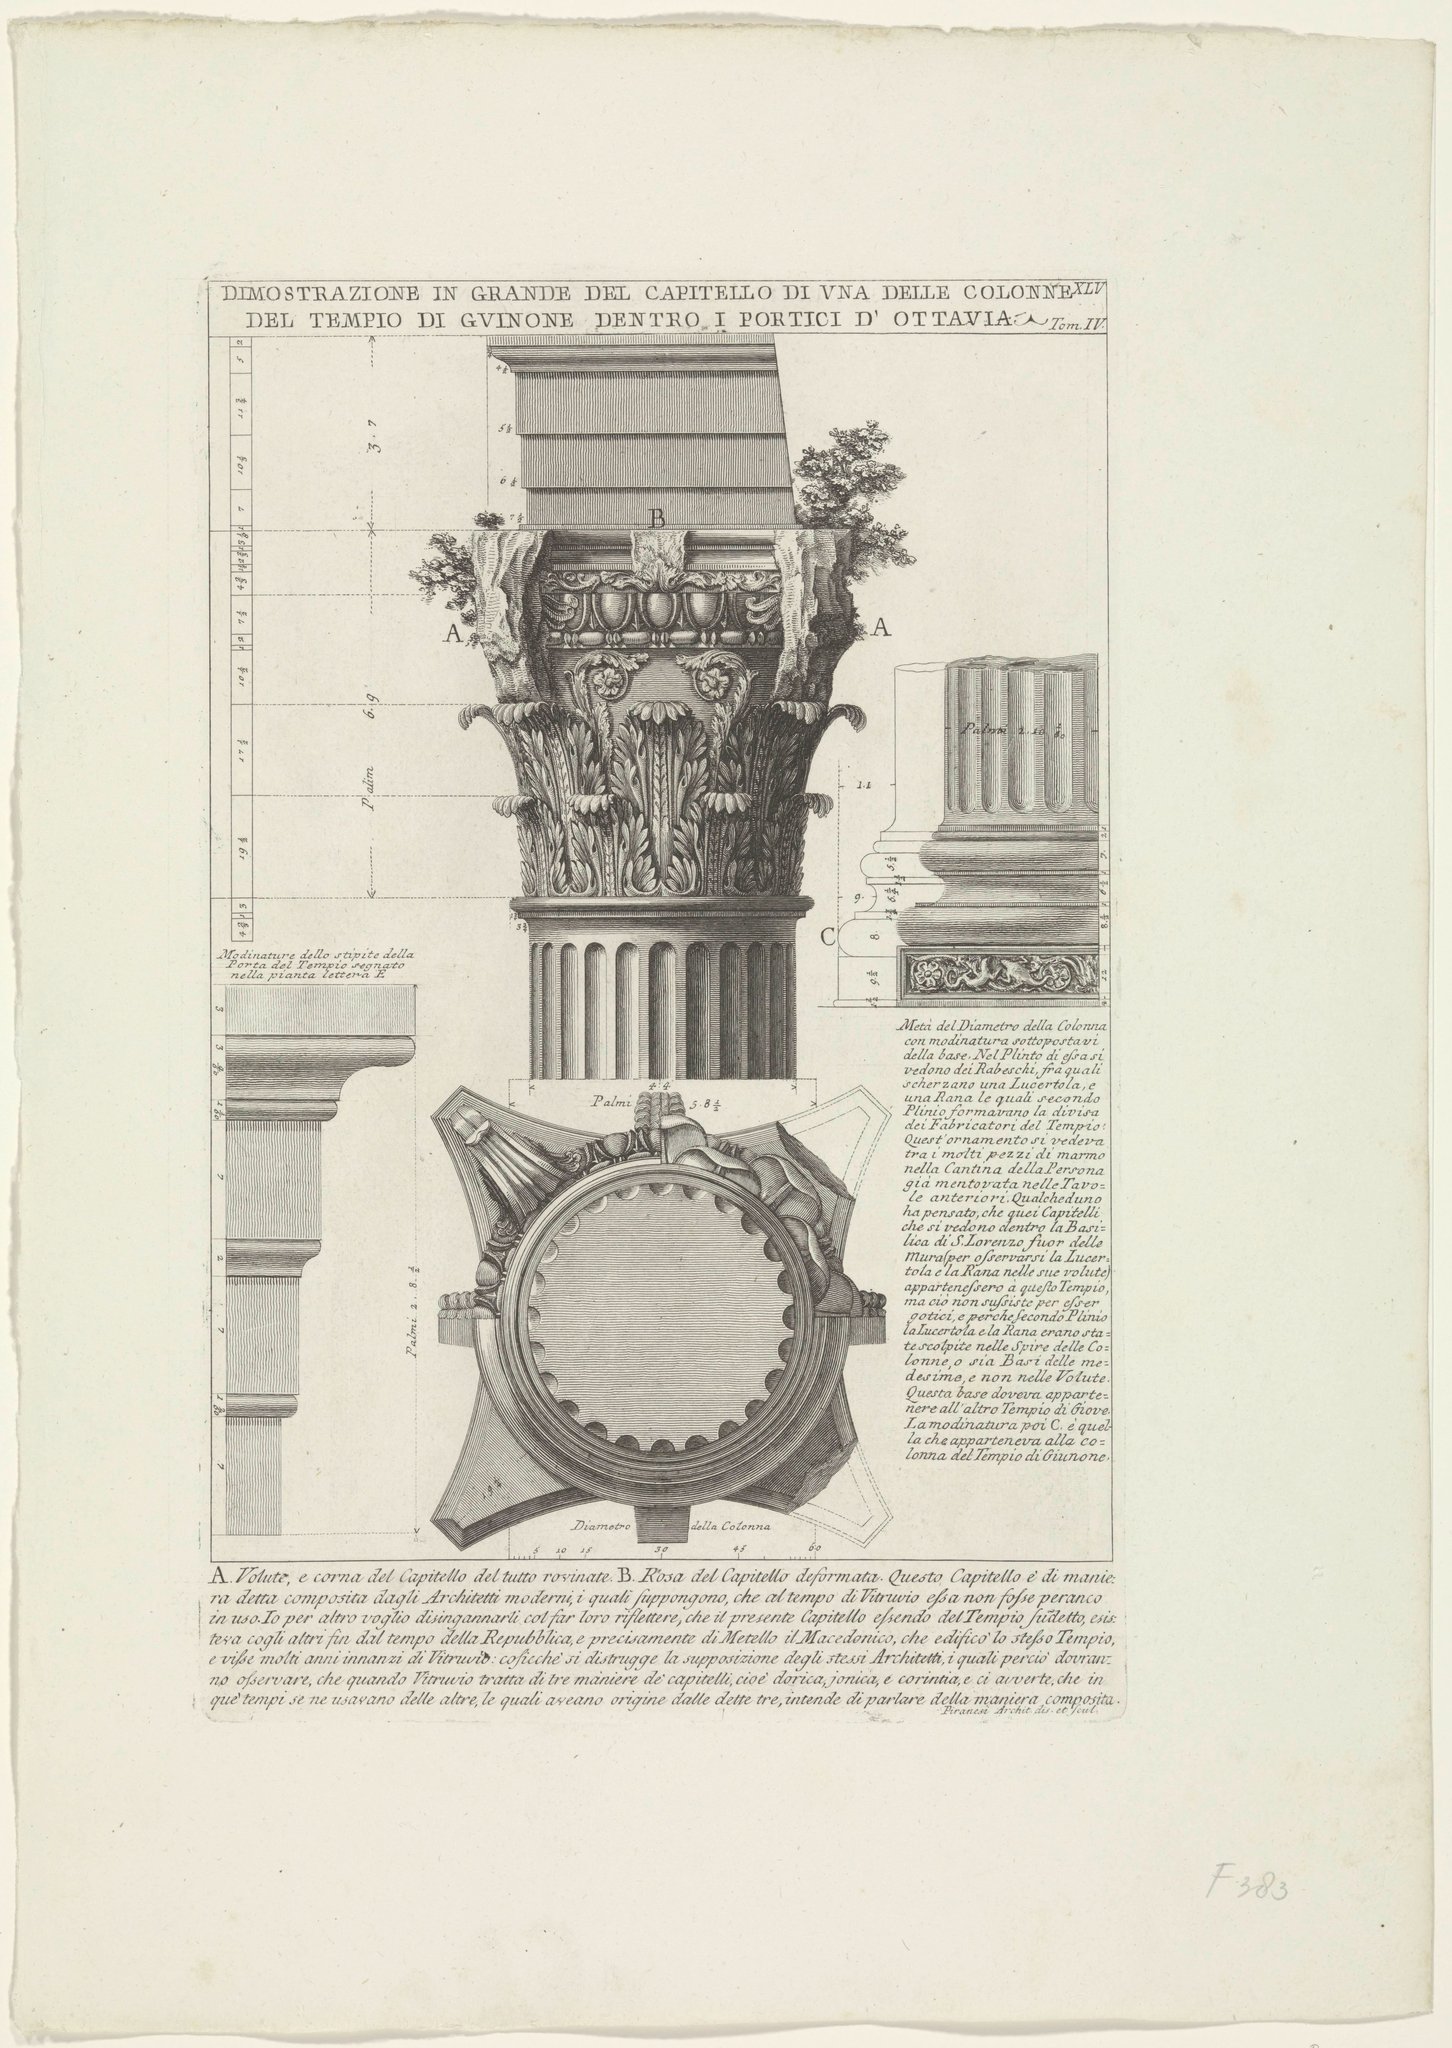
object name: print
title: Dimostrazione in grande del capitello di una delle colonne del tempio di Guinone dentro i portici d' Ottavia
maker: giovanni battista piranesi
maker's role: designer, draughtsman, print maker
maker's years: 1720-1778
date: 1756-1757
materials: paper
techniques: etching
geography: rome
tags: ruin of a building ~ architecture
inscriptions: collector's mark: Lugt 2228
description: Reconstructie van gedeelten van de Tempel van Juno Regina, die zich binnen de ommuring van de Poticus van Octavia te Rome bevond: het kapiteel van een Korinthische zuil, een kapiteel van onderen gezien, een kroonlijst en een basement van een zuil. Titel boven. Genummerd rechtsboven: XLV/ Tom. IV. Verklarende lijst met letters in ondermarge.